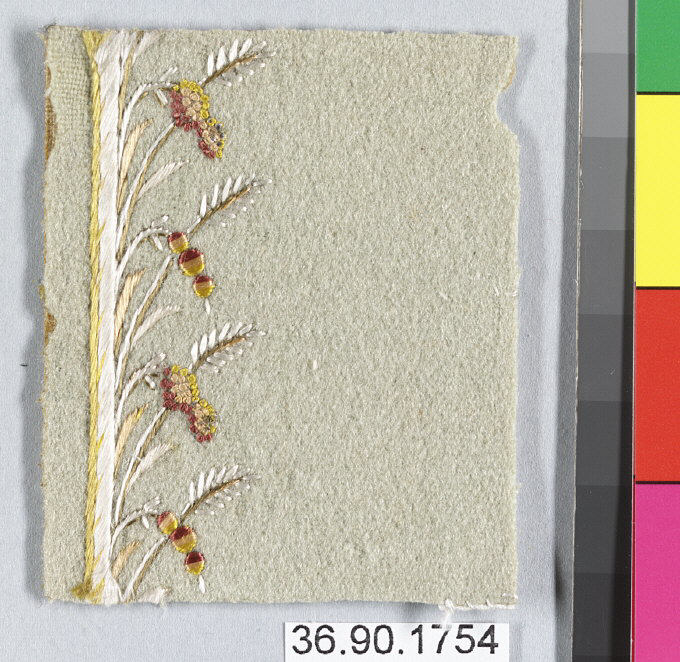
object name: sample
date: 1801-1833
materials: felt, silk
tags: plants